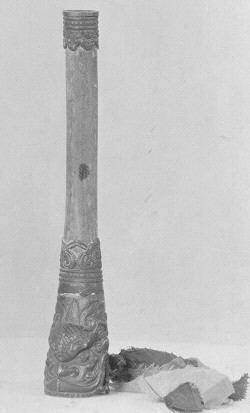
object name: kang t'ung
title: Kang-T'ung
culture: chinese or tibetan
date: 1867-1900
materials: copper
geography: china